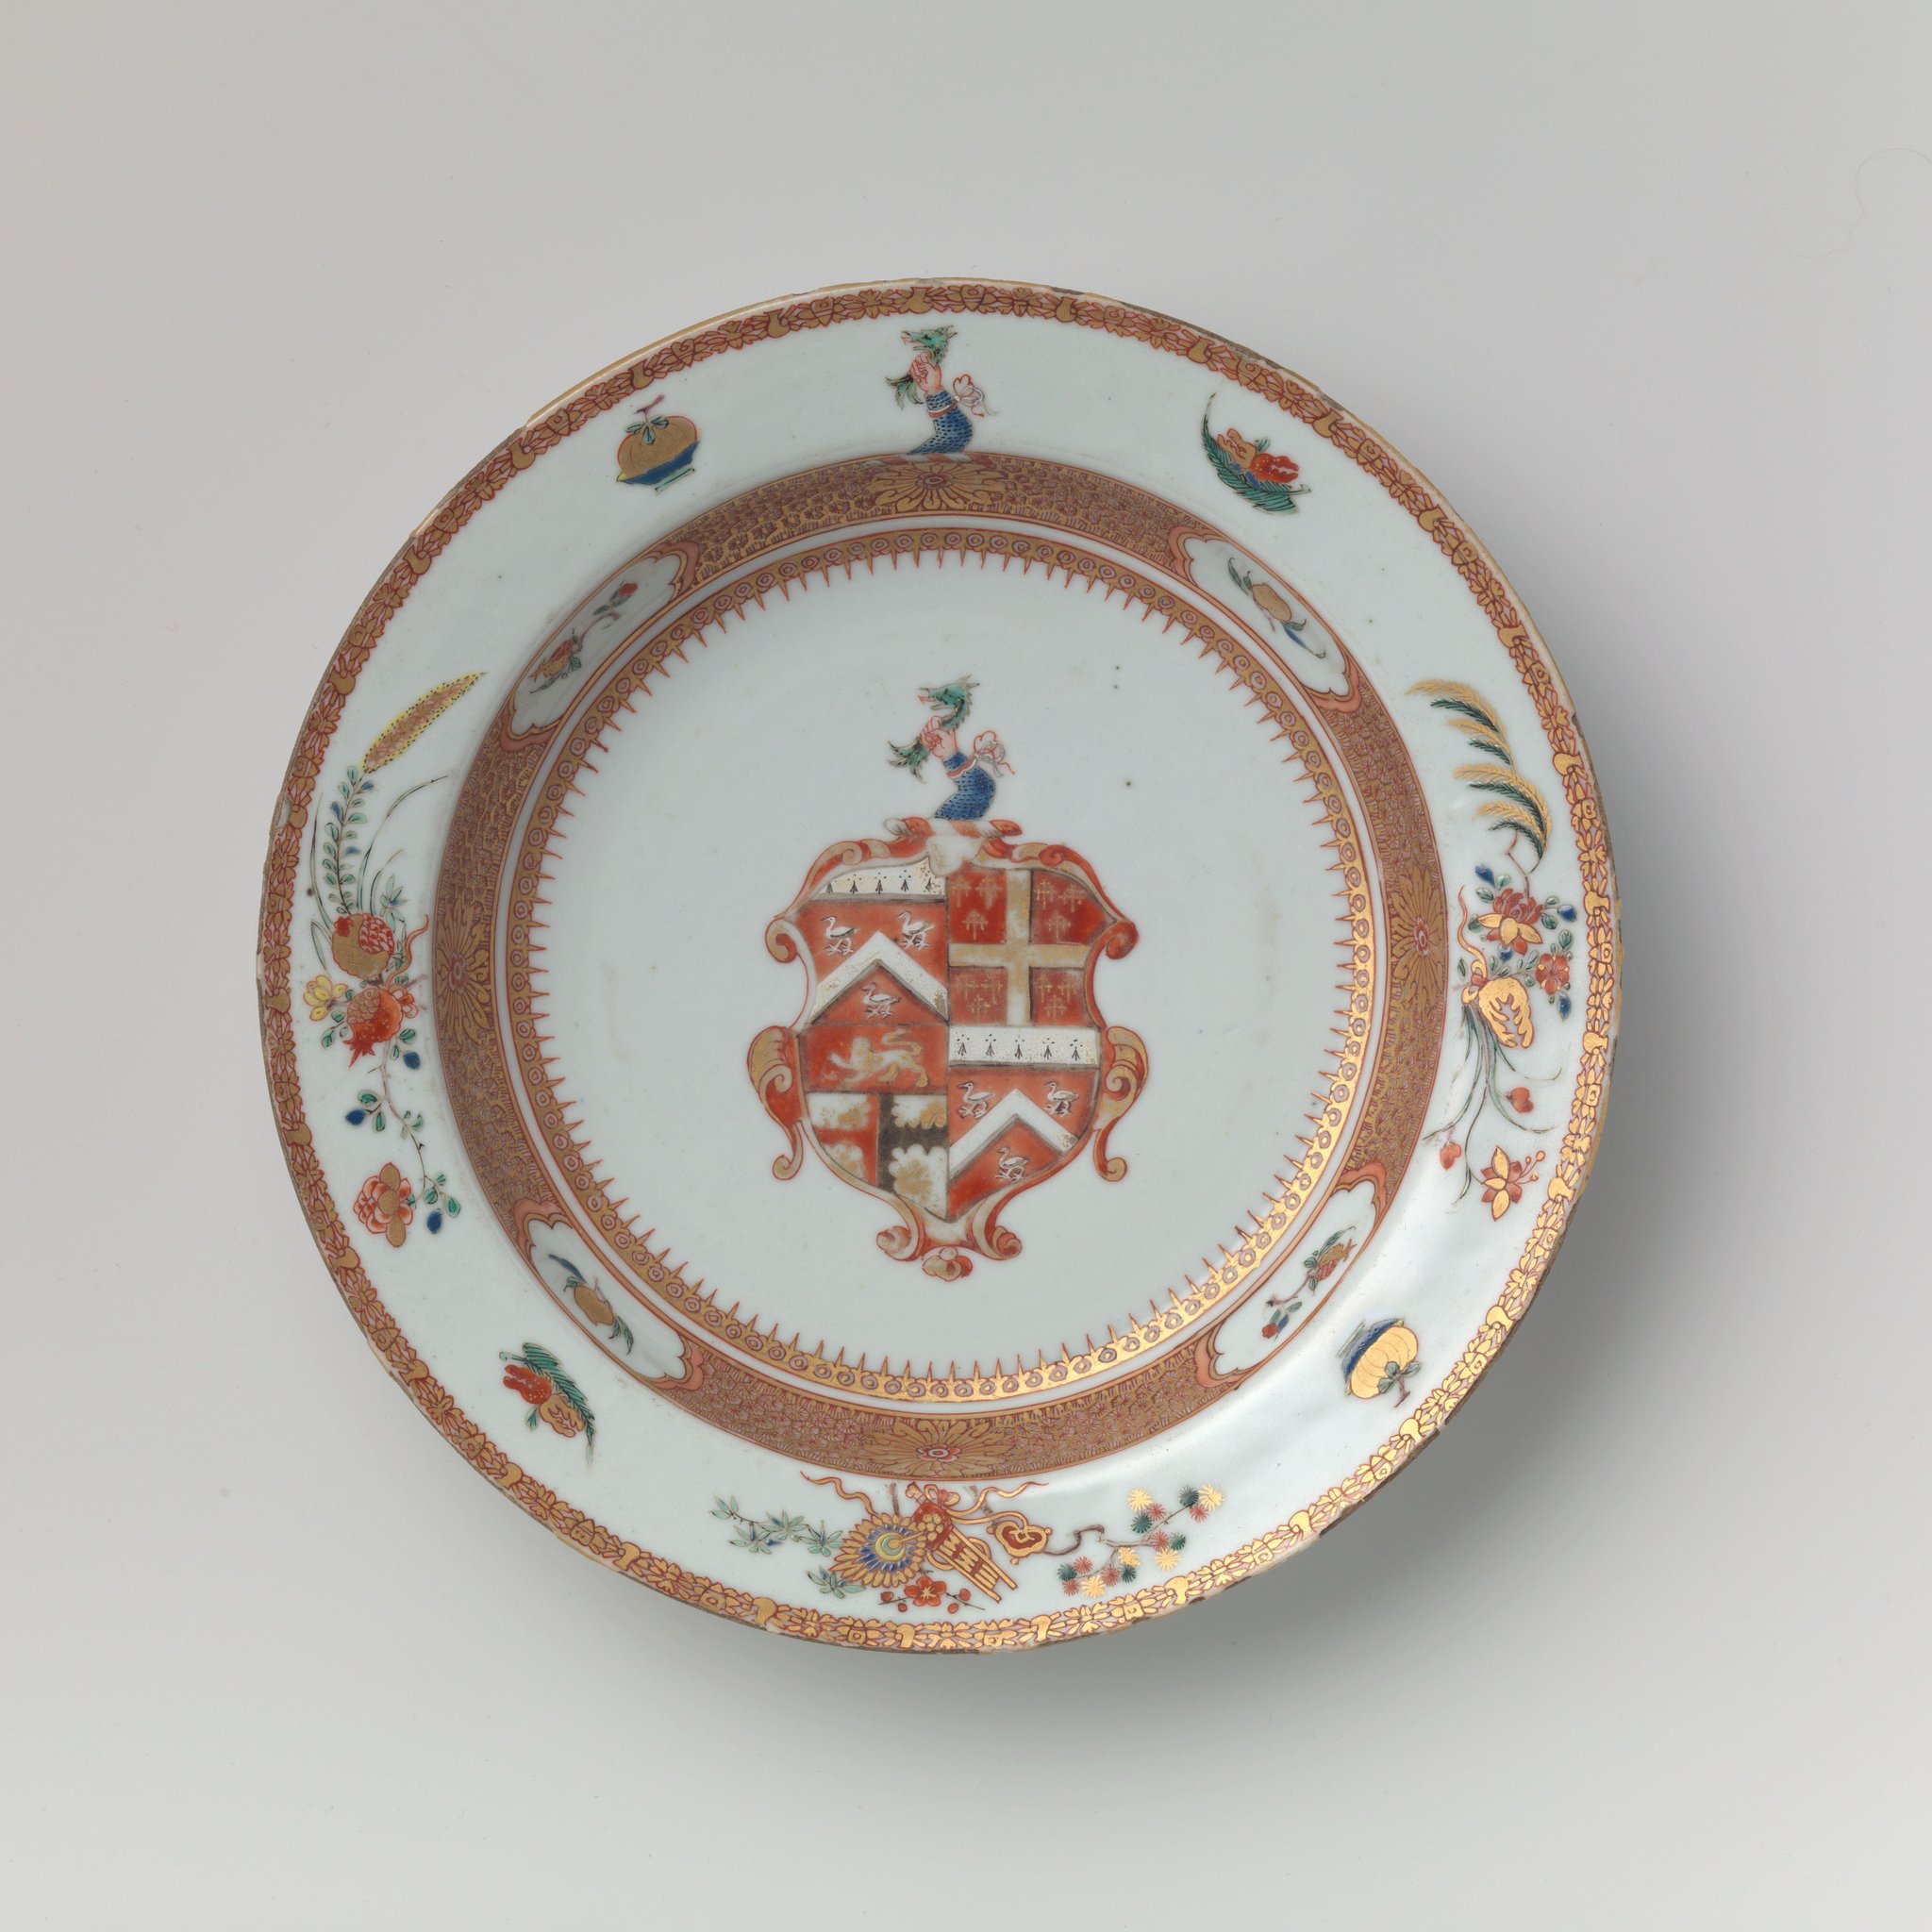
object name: plate dish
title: Soup plate with the arms of the Sayer, Woodhave and Brooke family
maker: Anonymous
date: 1725-1749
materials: glaze, gold, paint, porcelain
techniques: firing, gilding, turning, vitrification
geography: china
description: Diep bord beschilderd in ijzerrood en goud met in het centrum het gecombineerde wapen van de families Sayer, Woodhave en Brooke. Op de wand een ornamentale band en op de rand bloem- en vruchtentakken.